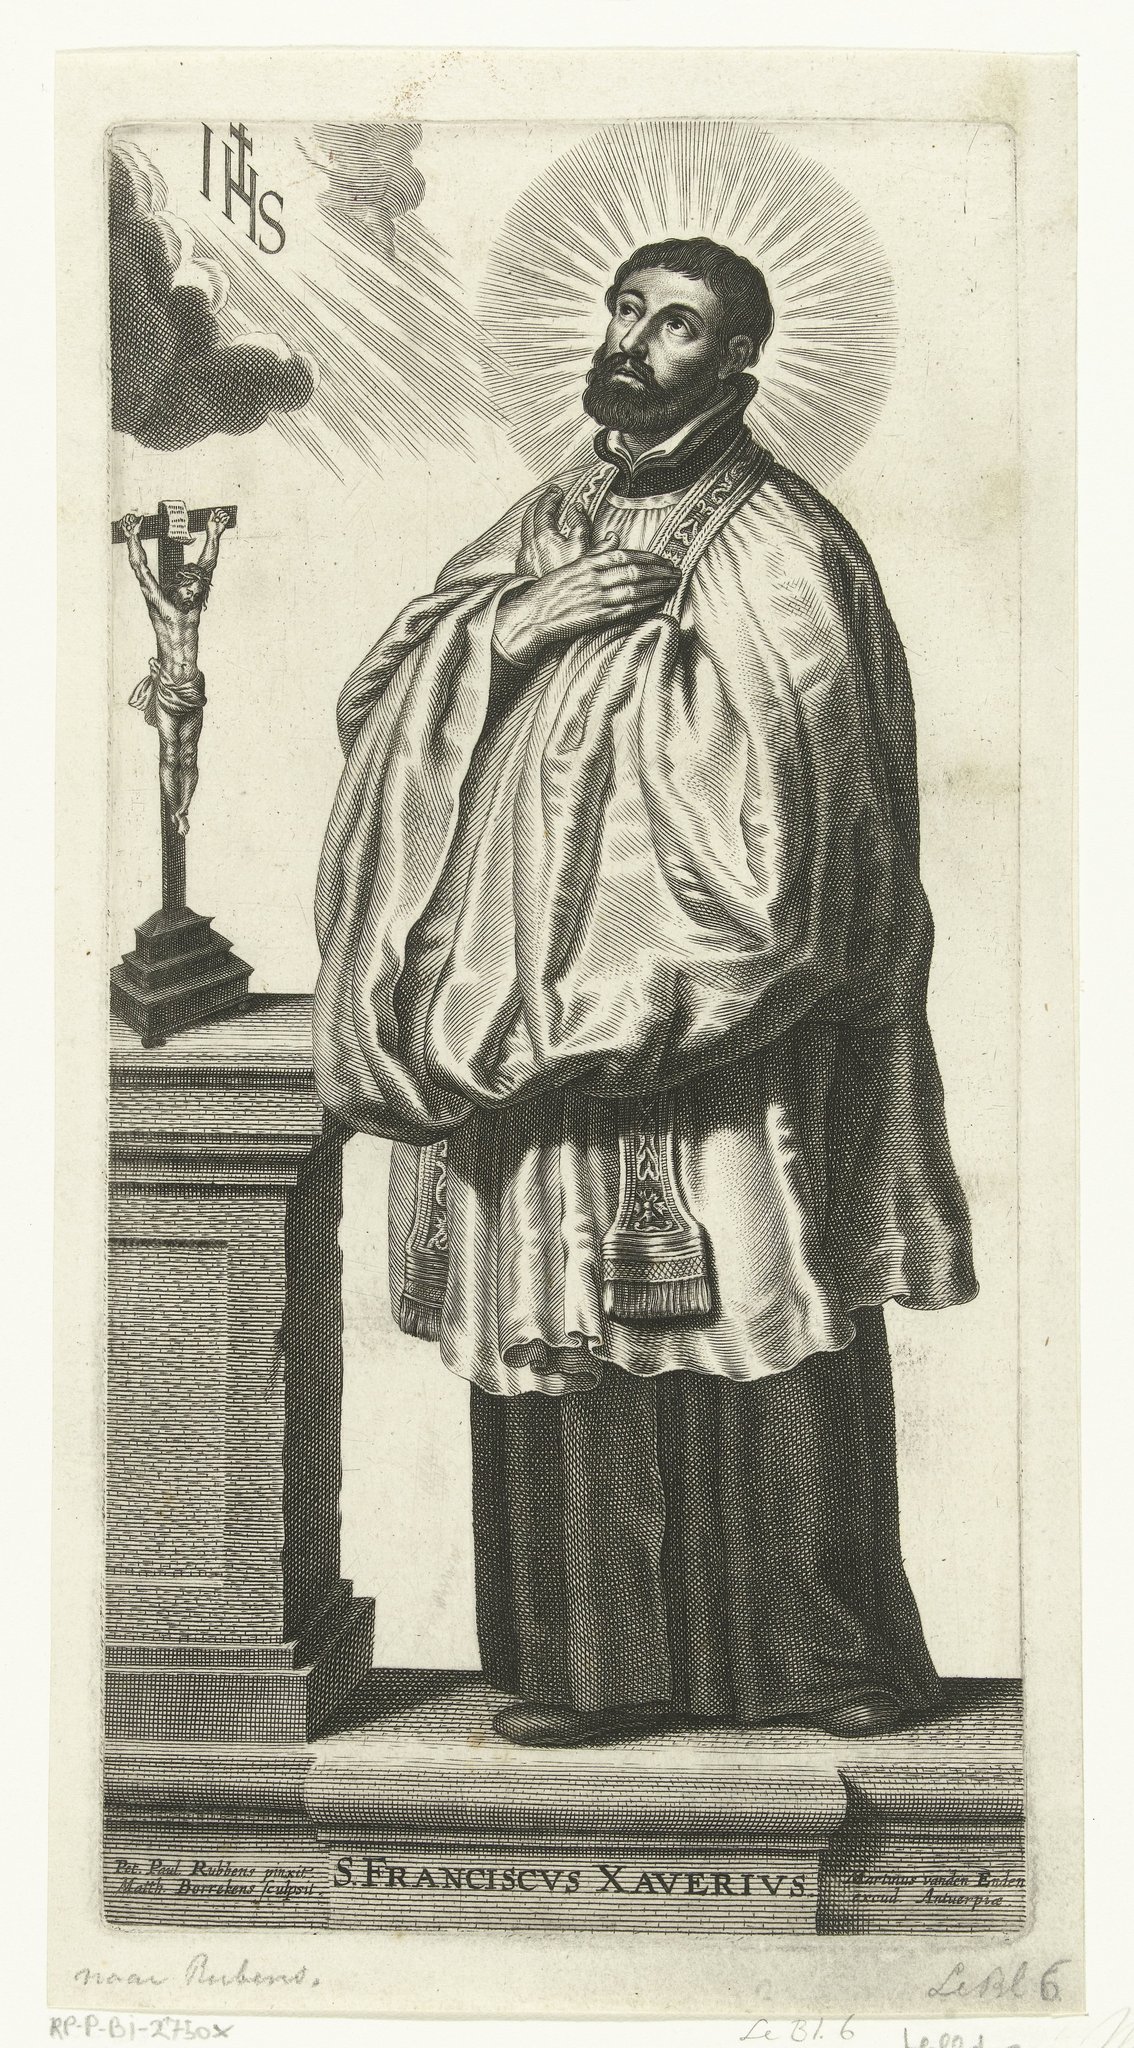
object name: print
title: Heilige Franciscus Xaverius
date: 1644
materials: paper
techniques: engraving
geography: antwerp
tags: the jesuit missionary francis xavier; possible attributes: cross, crucifix, flaming heart, indian, lily, torch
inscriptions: collector's mark: Lugt 240 of 1838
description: De Heilige Franciscus Xaverius, een priester Jezuïet uit de zestiende eeuw die missionaris was in India en Japan. Hij heeft een priestergewaad aan en staat voor een altaar met een kruisbeeld. Hij houdt zijn armen voor zijn borst. Hij heeft een aureool rond zijn hoofd.